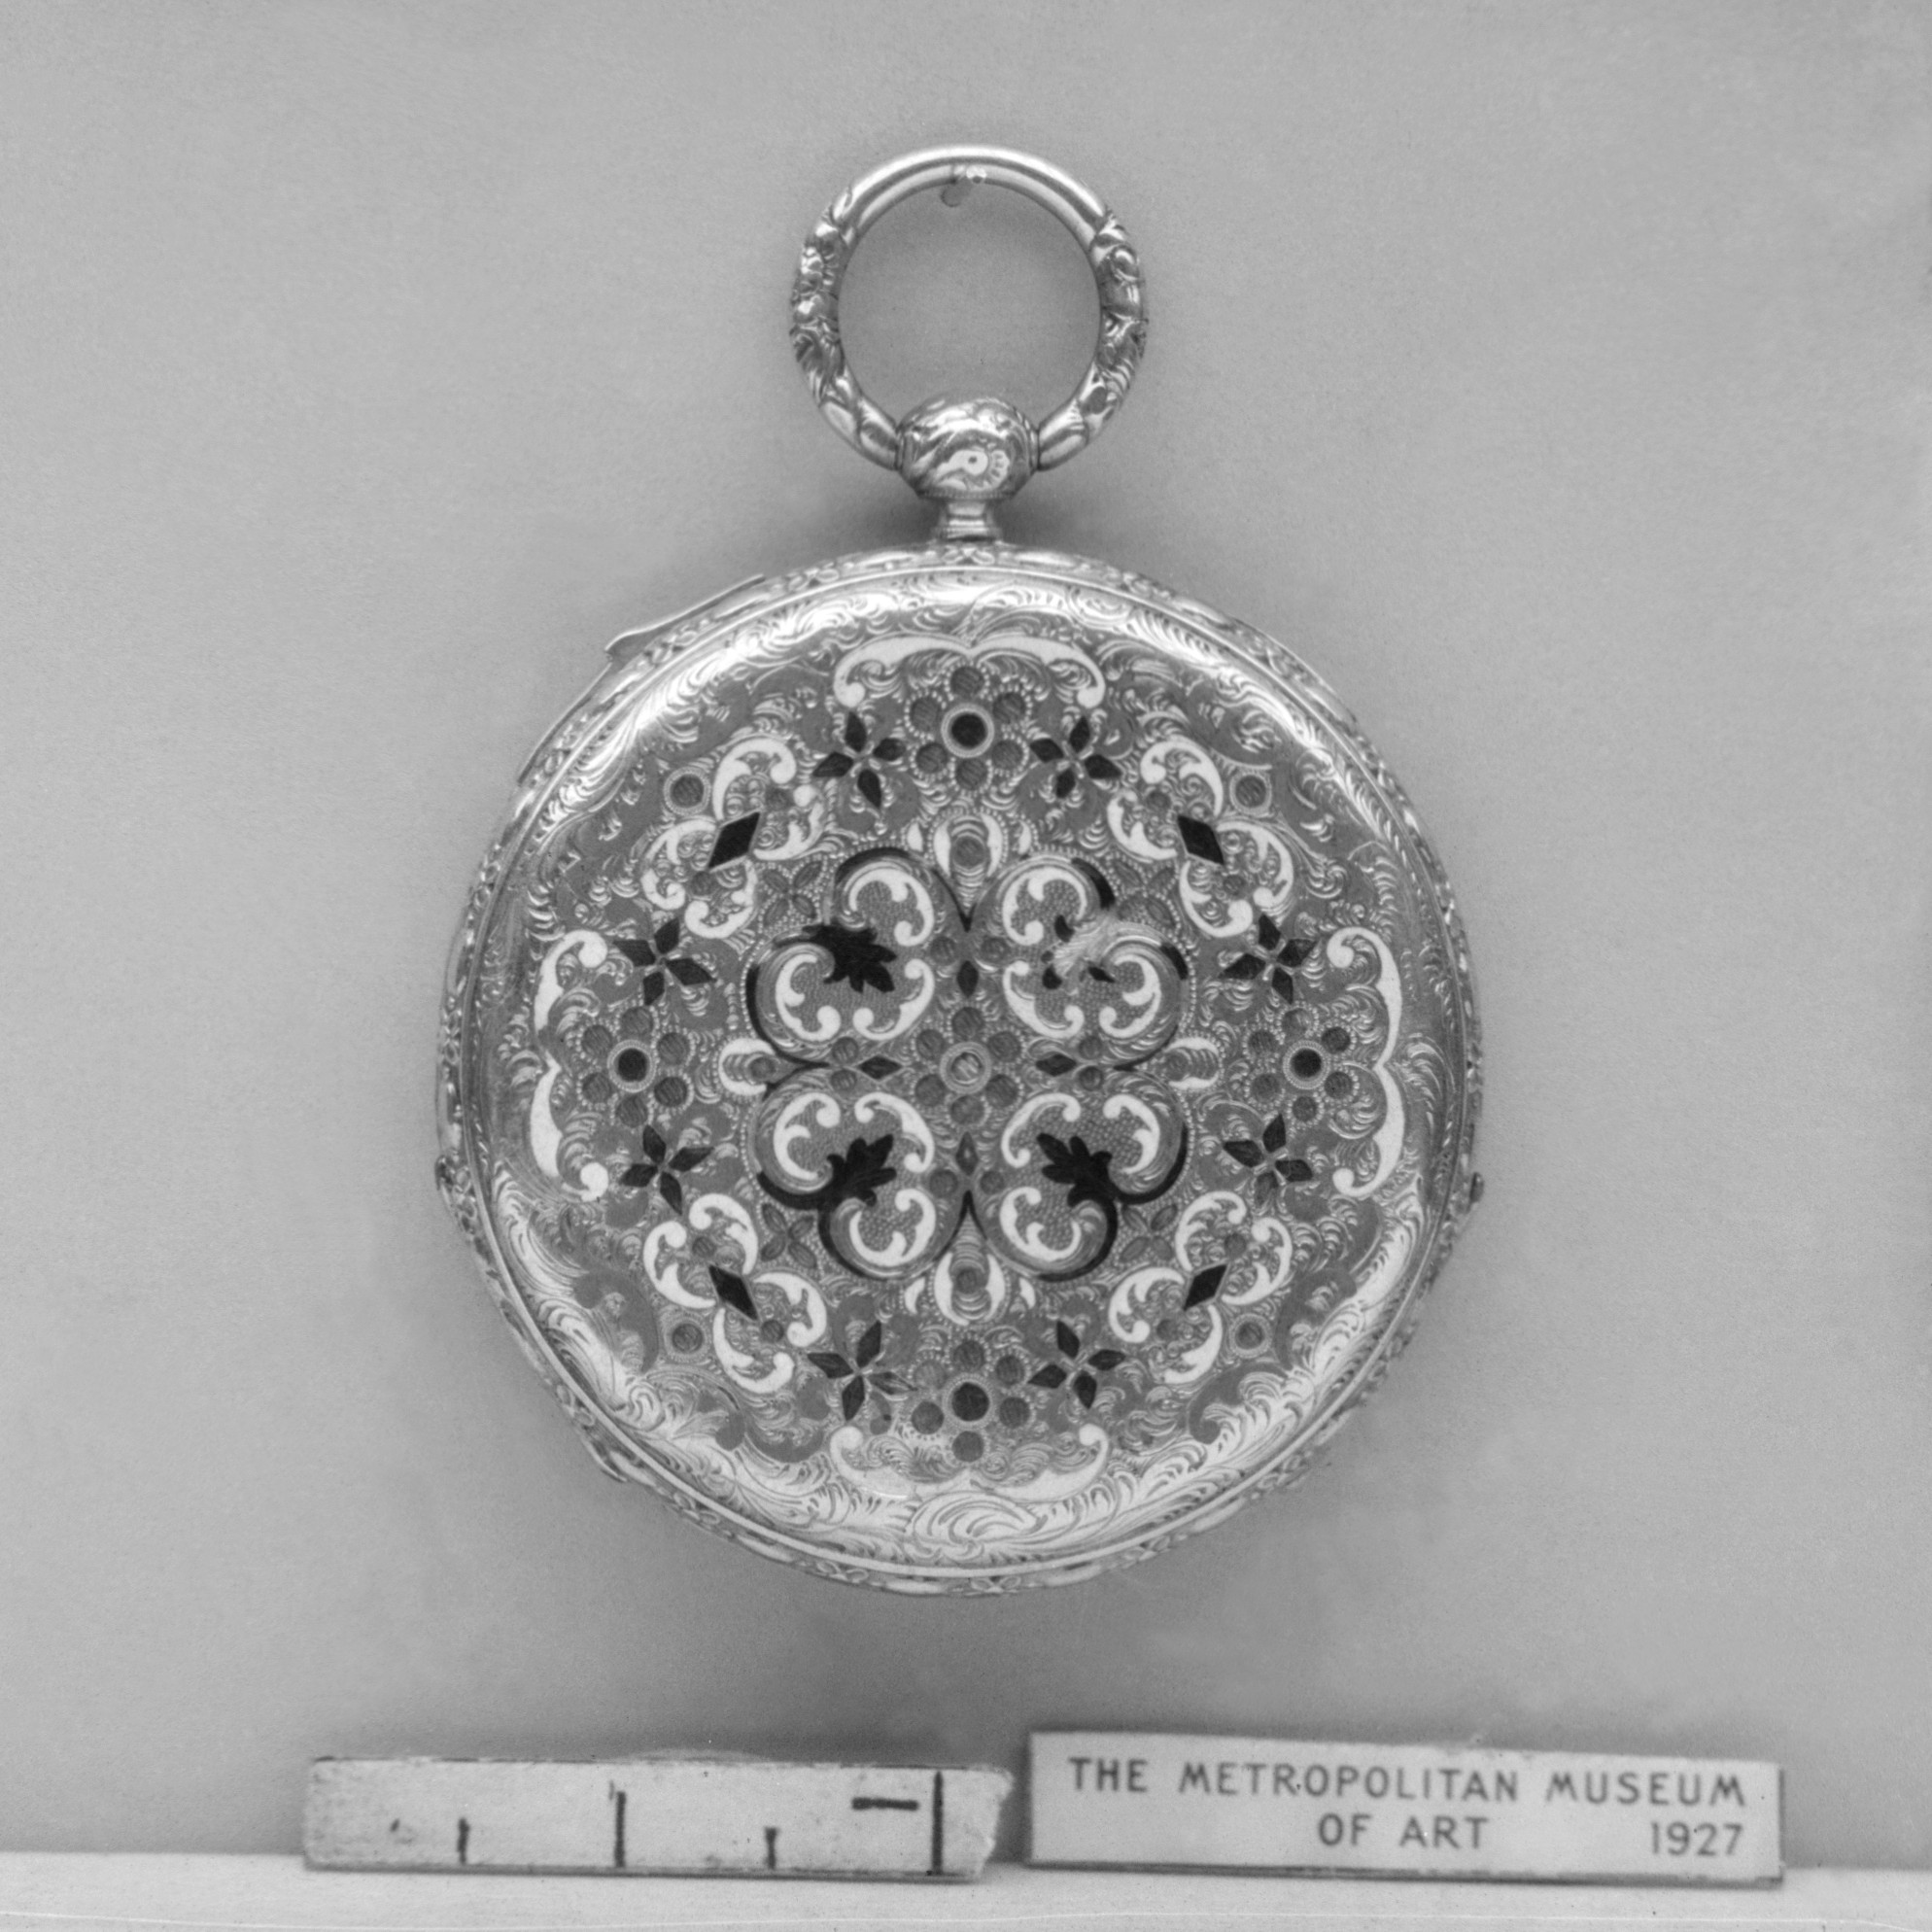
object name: watch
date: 1840-1860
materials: enamel, gold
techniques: enamel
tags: flowers